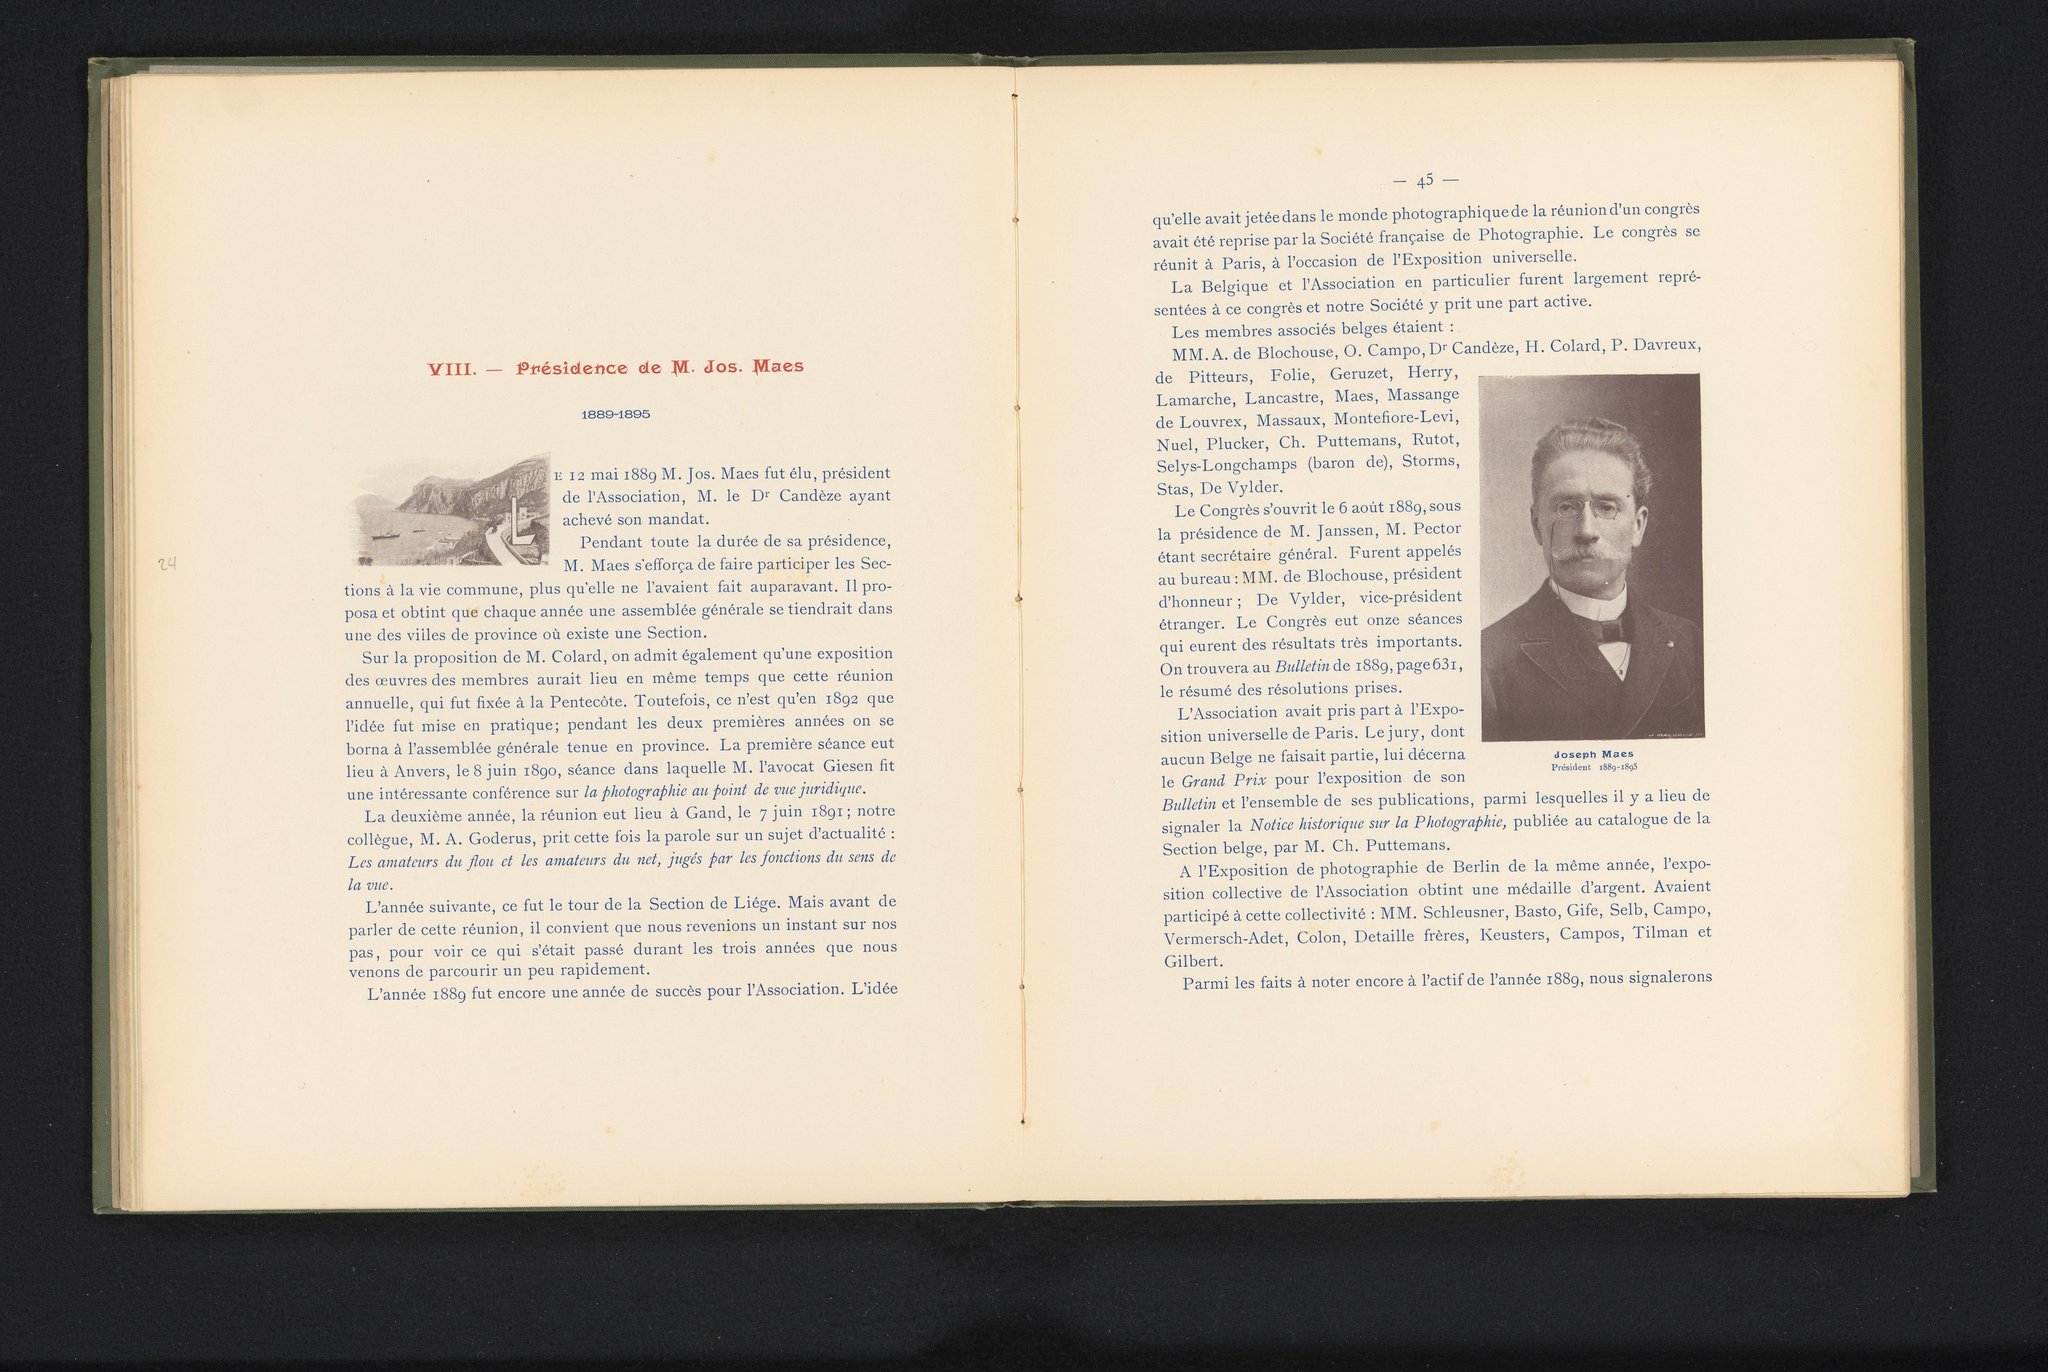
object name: photomechanical print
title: Stadsgezicht met zee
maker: Anonymous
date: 1893-1898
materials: paper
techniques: autotype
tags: city-view in general; 'veduta', sea